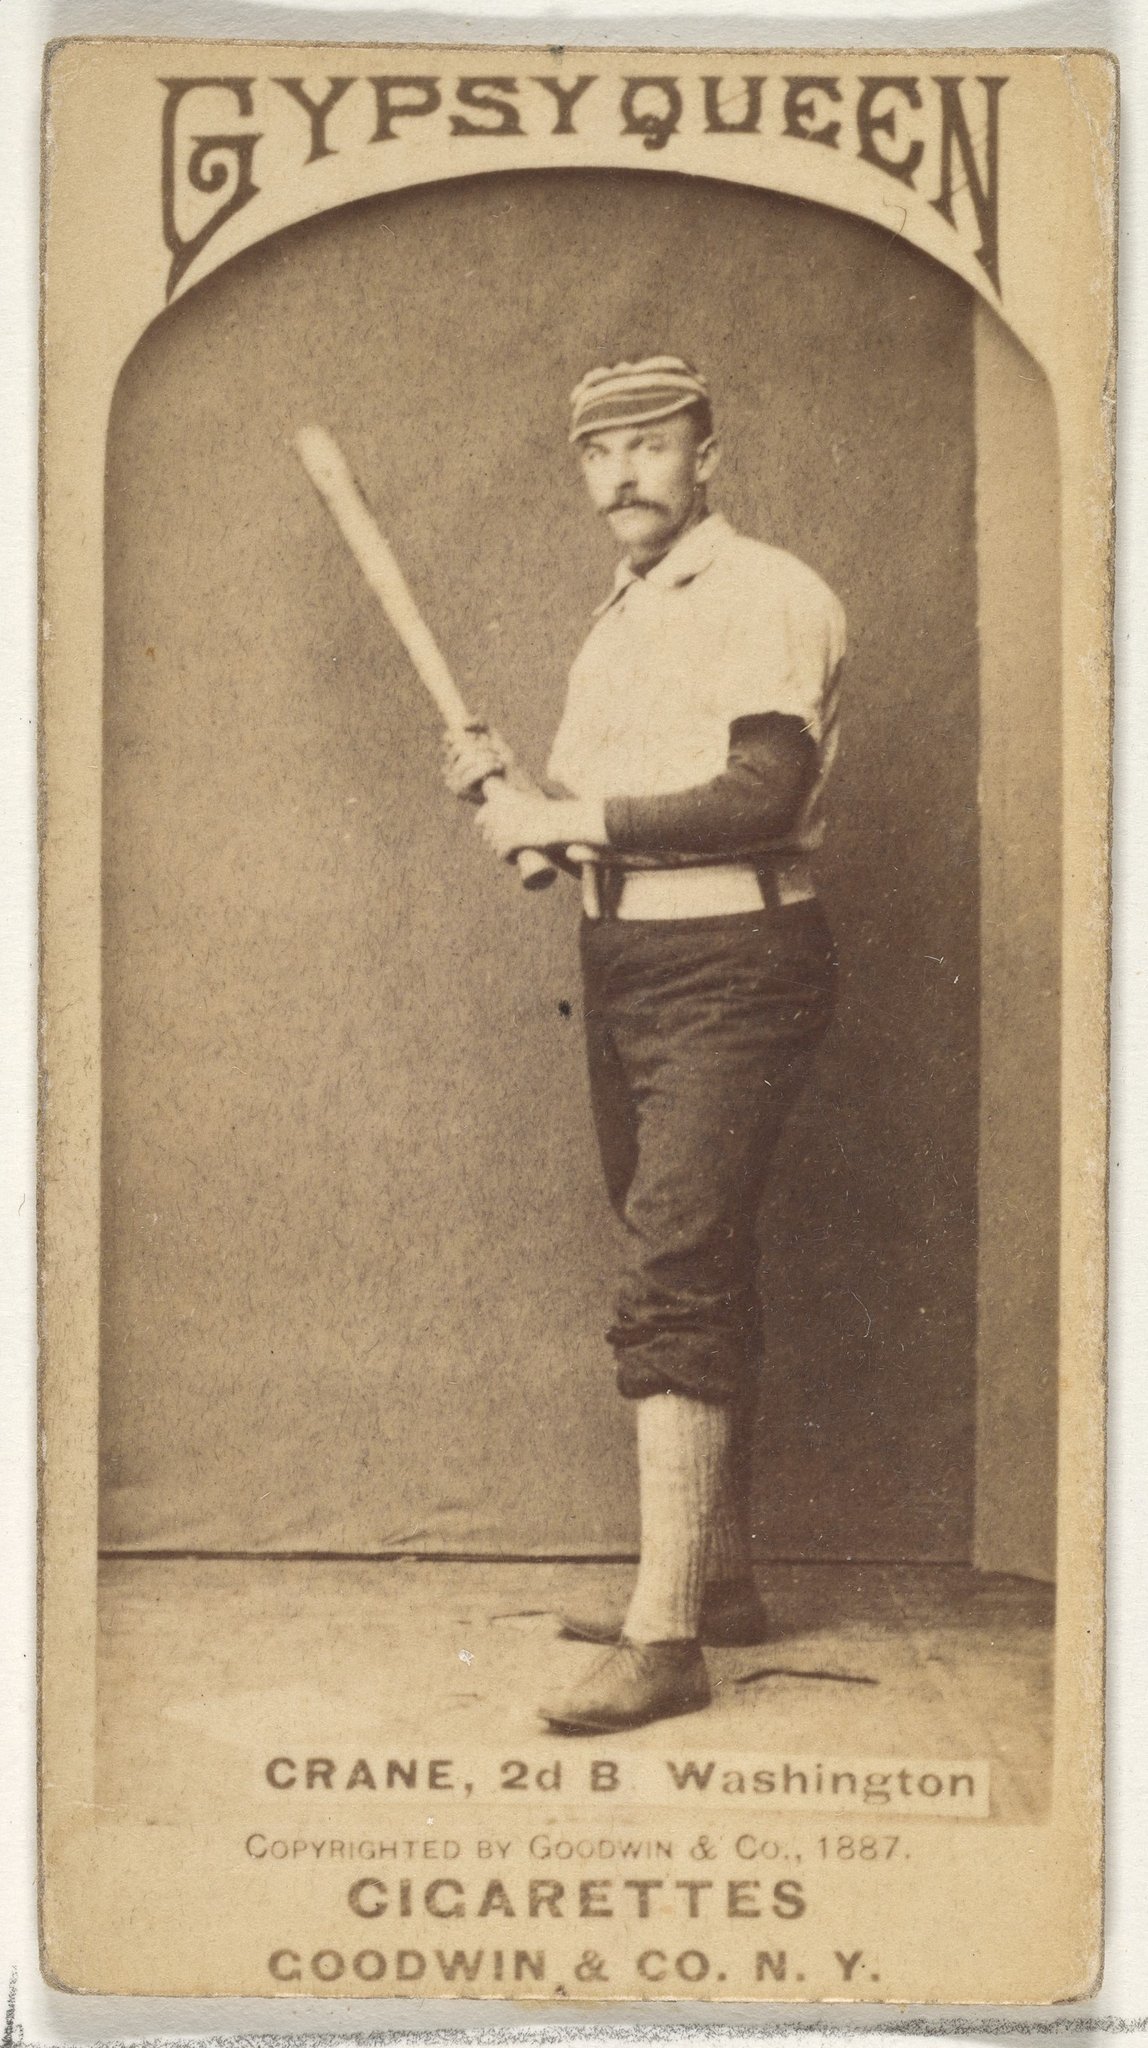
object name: baseball card, photograph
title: Samuel "Sam" Newhall Crane, 2nd Base, Washington Nationals, from the Old Judge series (N172) for Old Judge and Gypsy Queen Cigarettes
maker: goodwin & company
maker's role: publisher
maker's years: 1850-1950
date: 1887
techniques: albumen silver print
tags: men,portraits,baseball,athletes